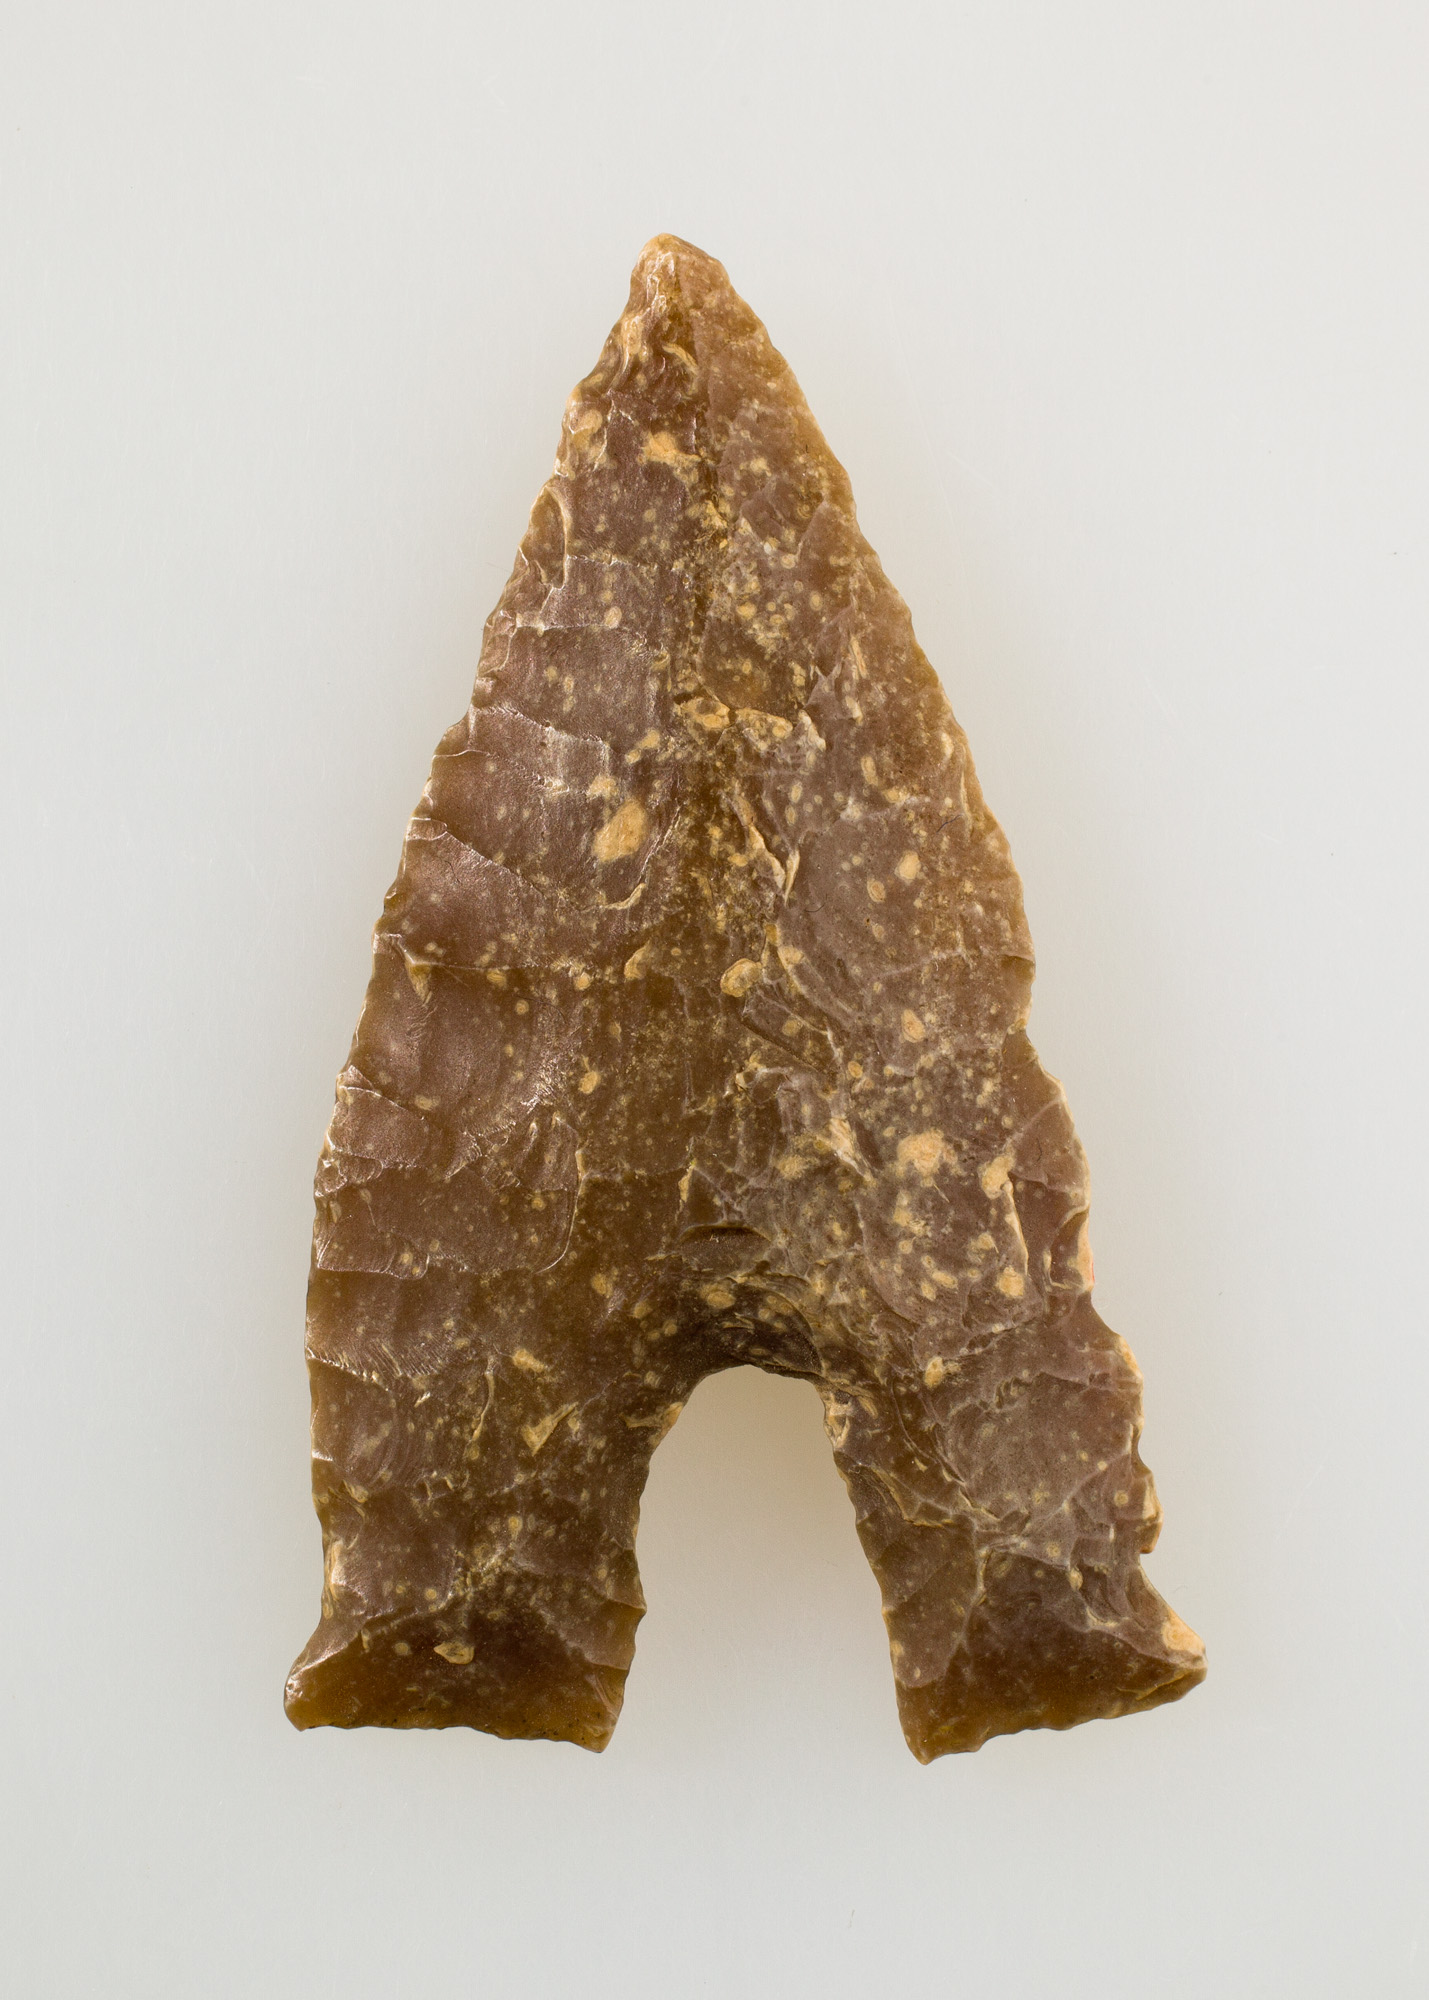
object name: arrowhead, hollow base, projectile point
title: Hollow-Base Projectile Point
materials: stone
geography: egypt